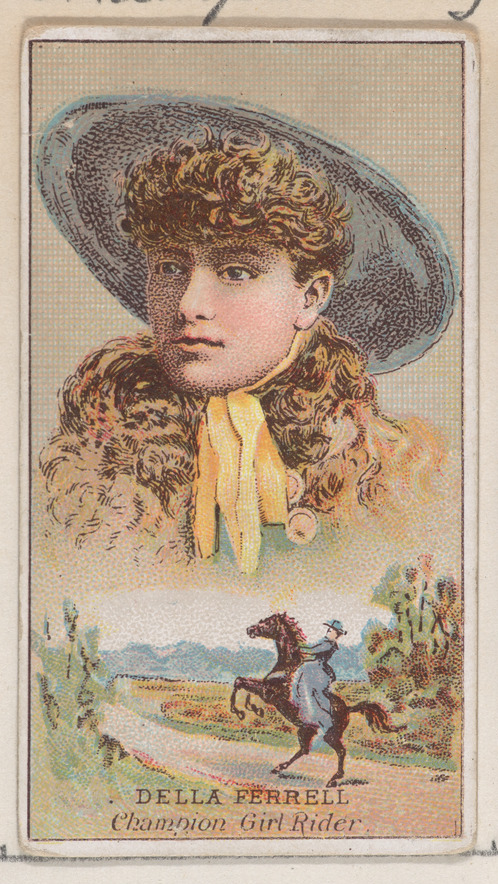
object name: print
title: Della Ferrell, Champion Girl Rider, from the Champions of Games and Sports series (N184, Type 2) issued by W.S. Kimball & Co.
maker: w.s. kimball & co.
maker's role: publisher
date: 1887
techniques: color lithograph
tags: women